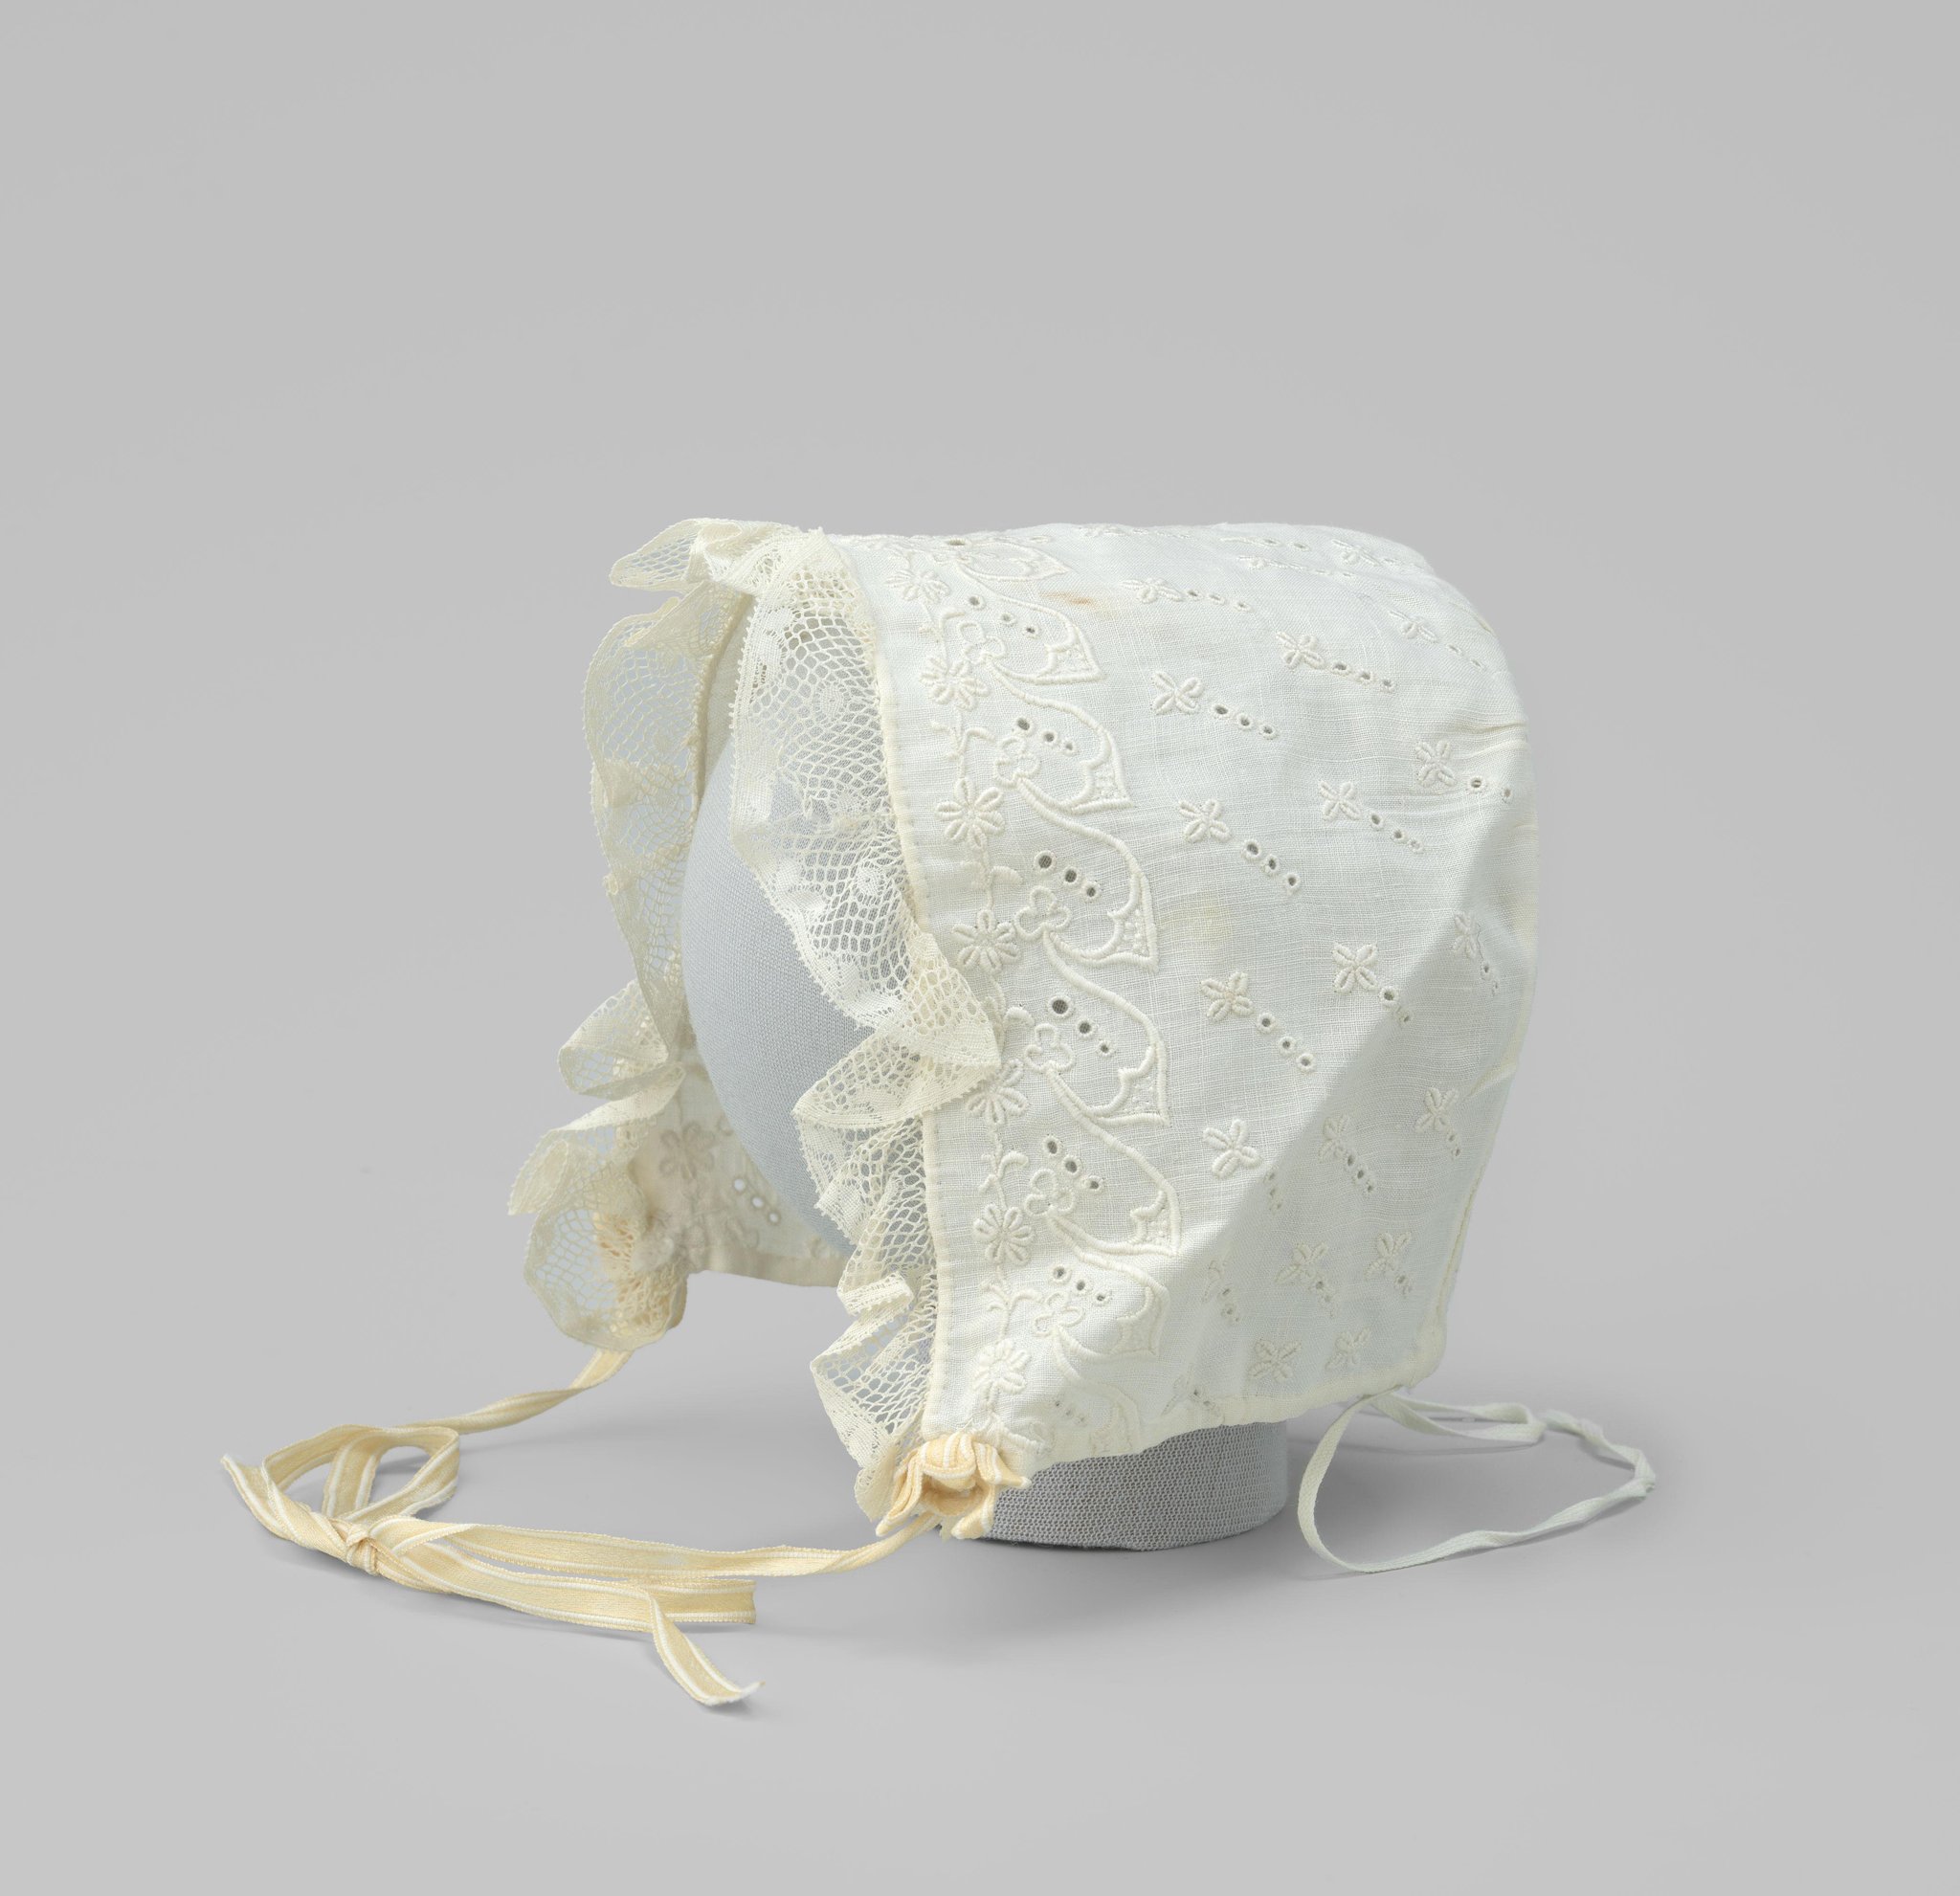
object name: babymuts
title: Babymuts van wit textiel met gerimpeld aangezettestrook kant met picots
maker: Anonymous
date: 1800-1900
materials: textile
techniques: embroidered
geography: netherlands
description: Aan weerszijden zitten twee rozetten met daaraan een lint waarmee de muts kan worden bevestigd.